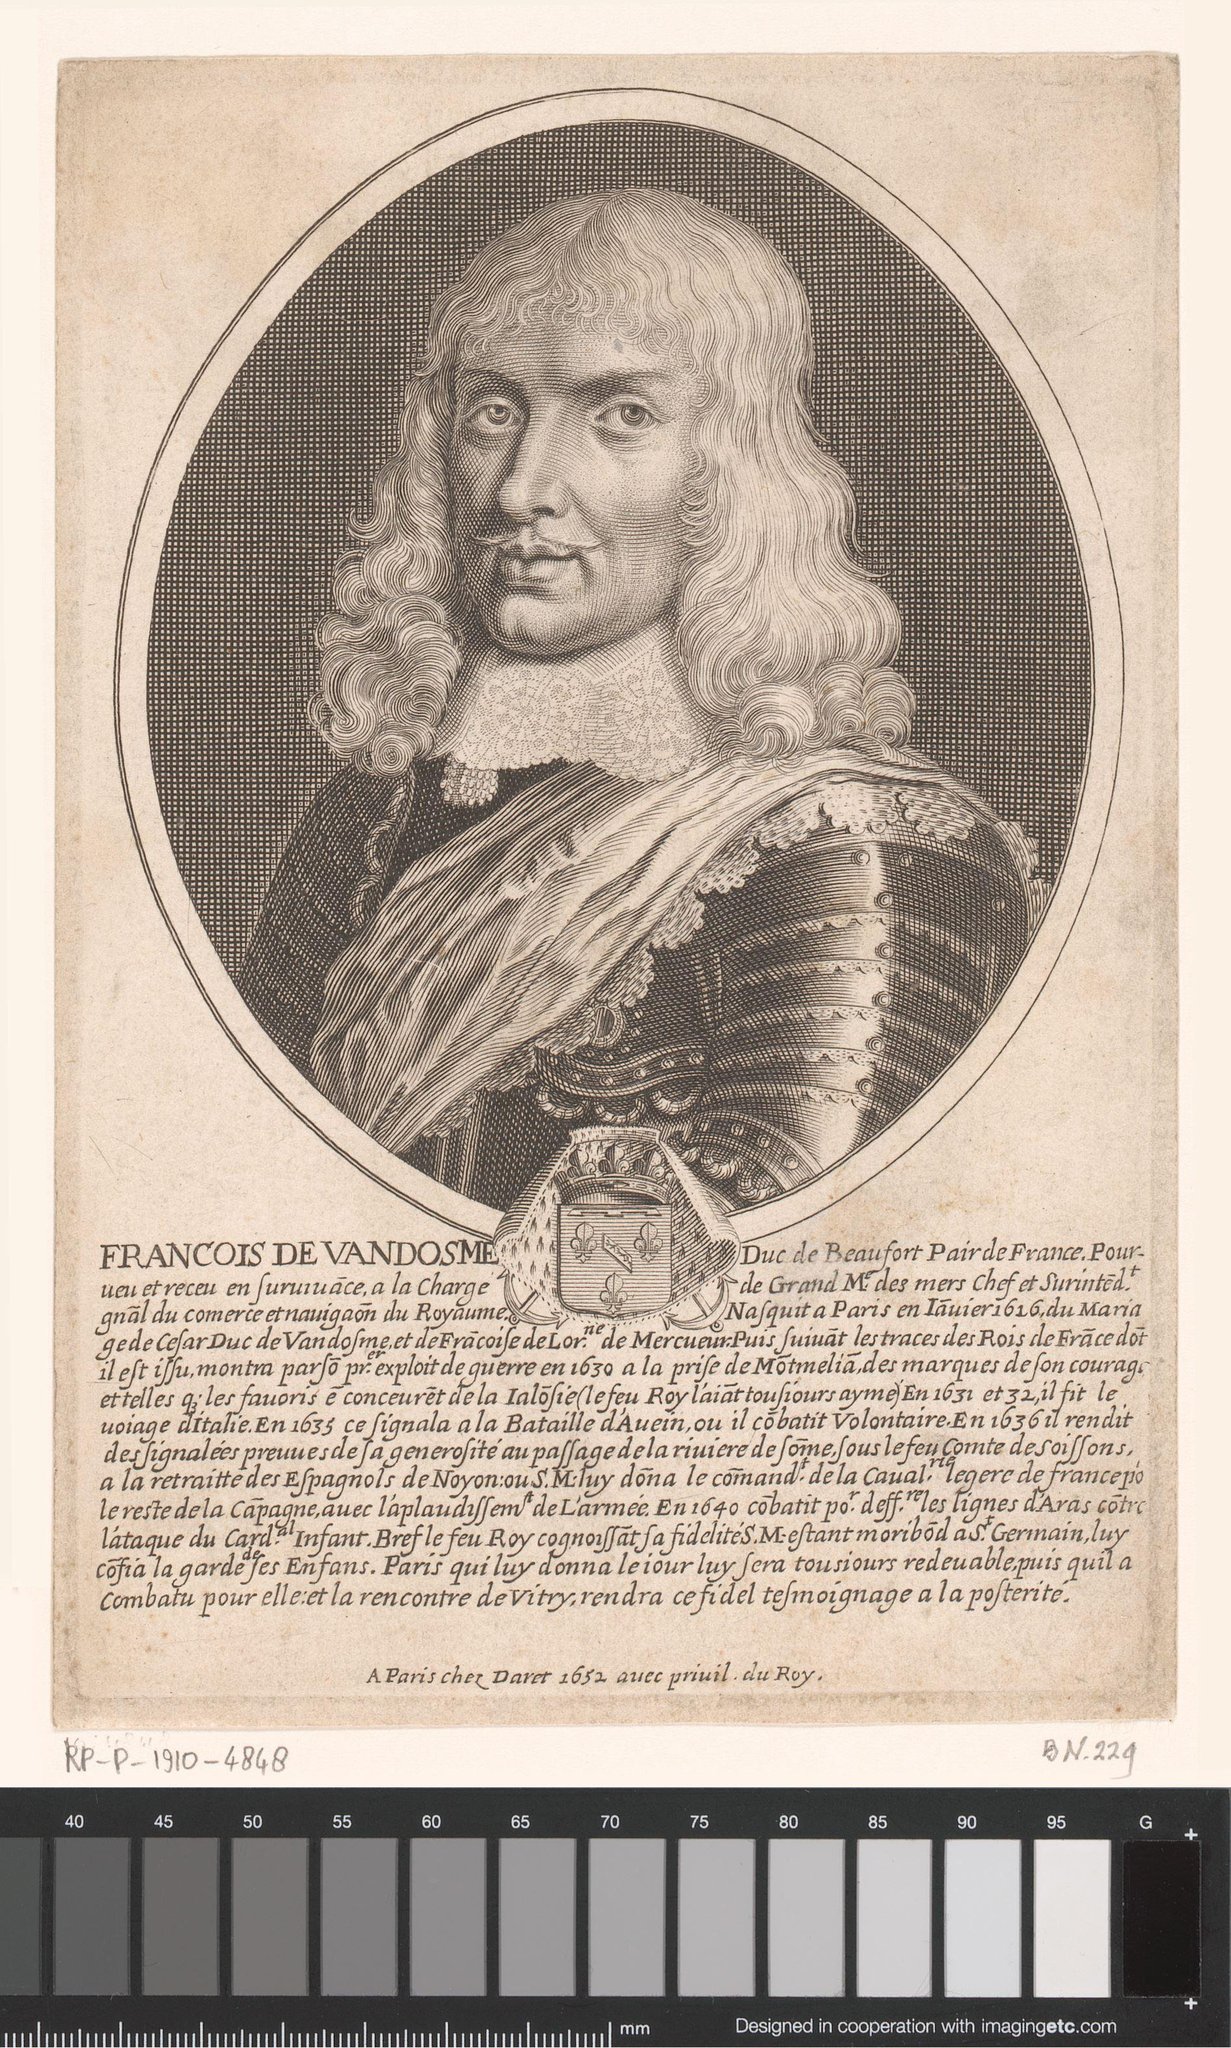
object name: print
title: Portretten van bekende historische figuren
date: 1652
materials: paper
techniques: engraving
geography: paris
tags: historical persons, armorial bearing, heraldry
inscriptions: collector's mark: Lugt 2228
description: Maakt deel uit van een serie portretten getiteld 'Tableaux historiques ou sont gravez les Illustres François et Etrangiers de l'un et l'autre sexe (...)', voor het eerst uitgegeven in 1652 door Daret. Een tweede staat werd uitgegeven door Boissevin en een derde door Jollain.